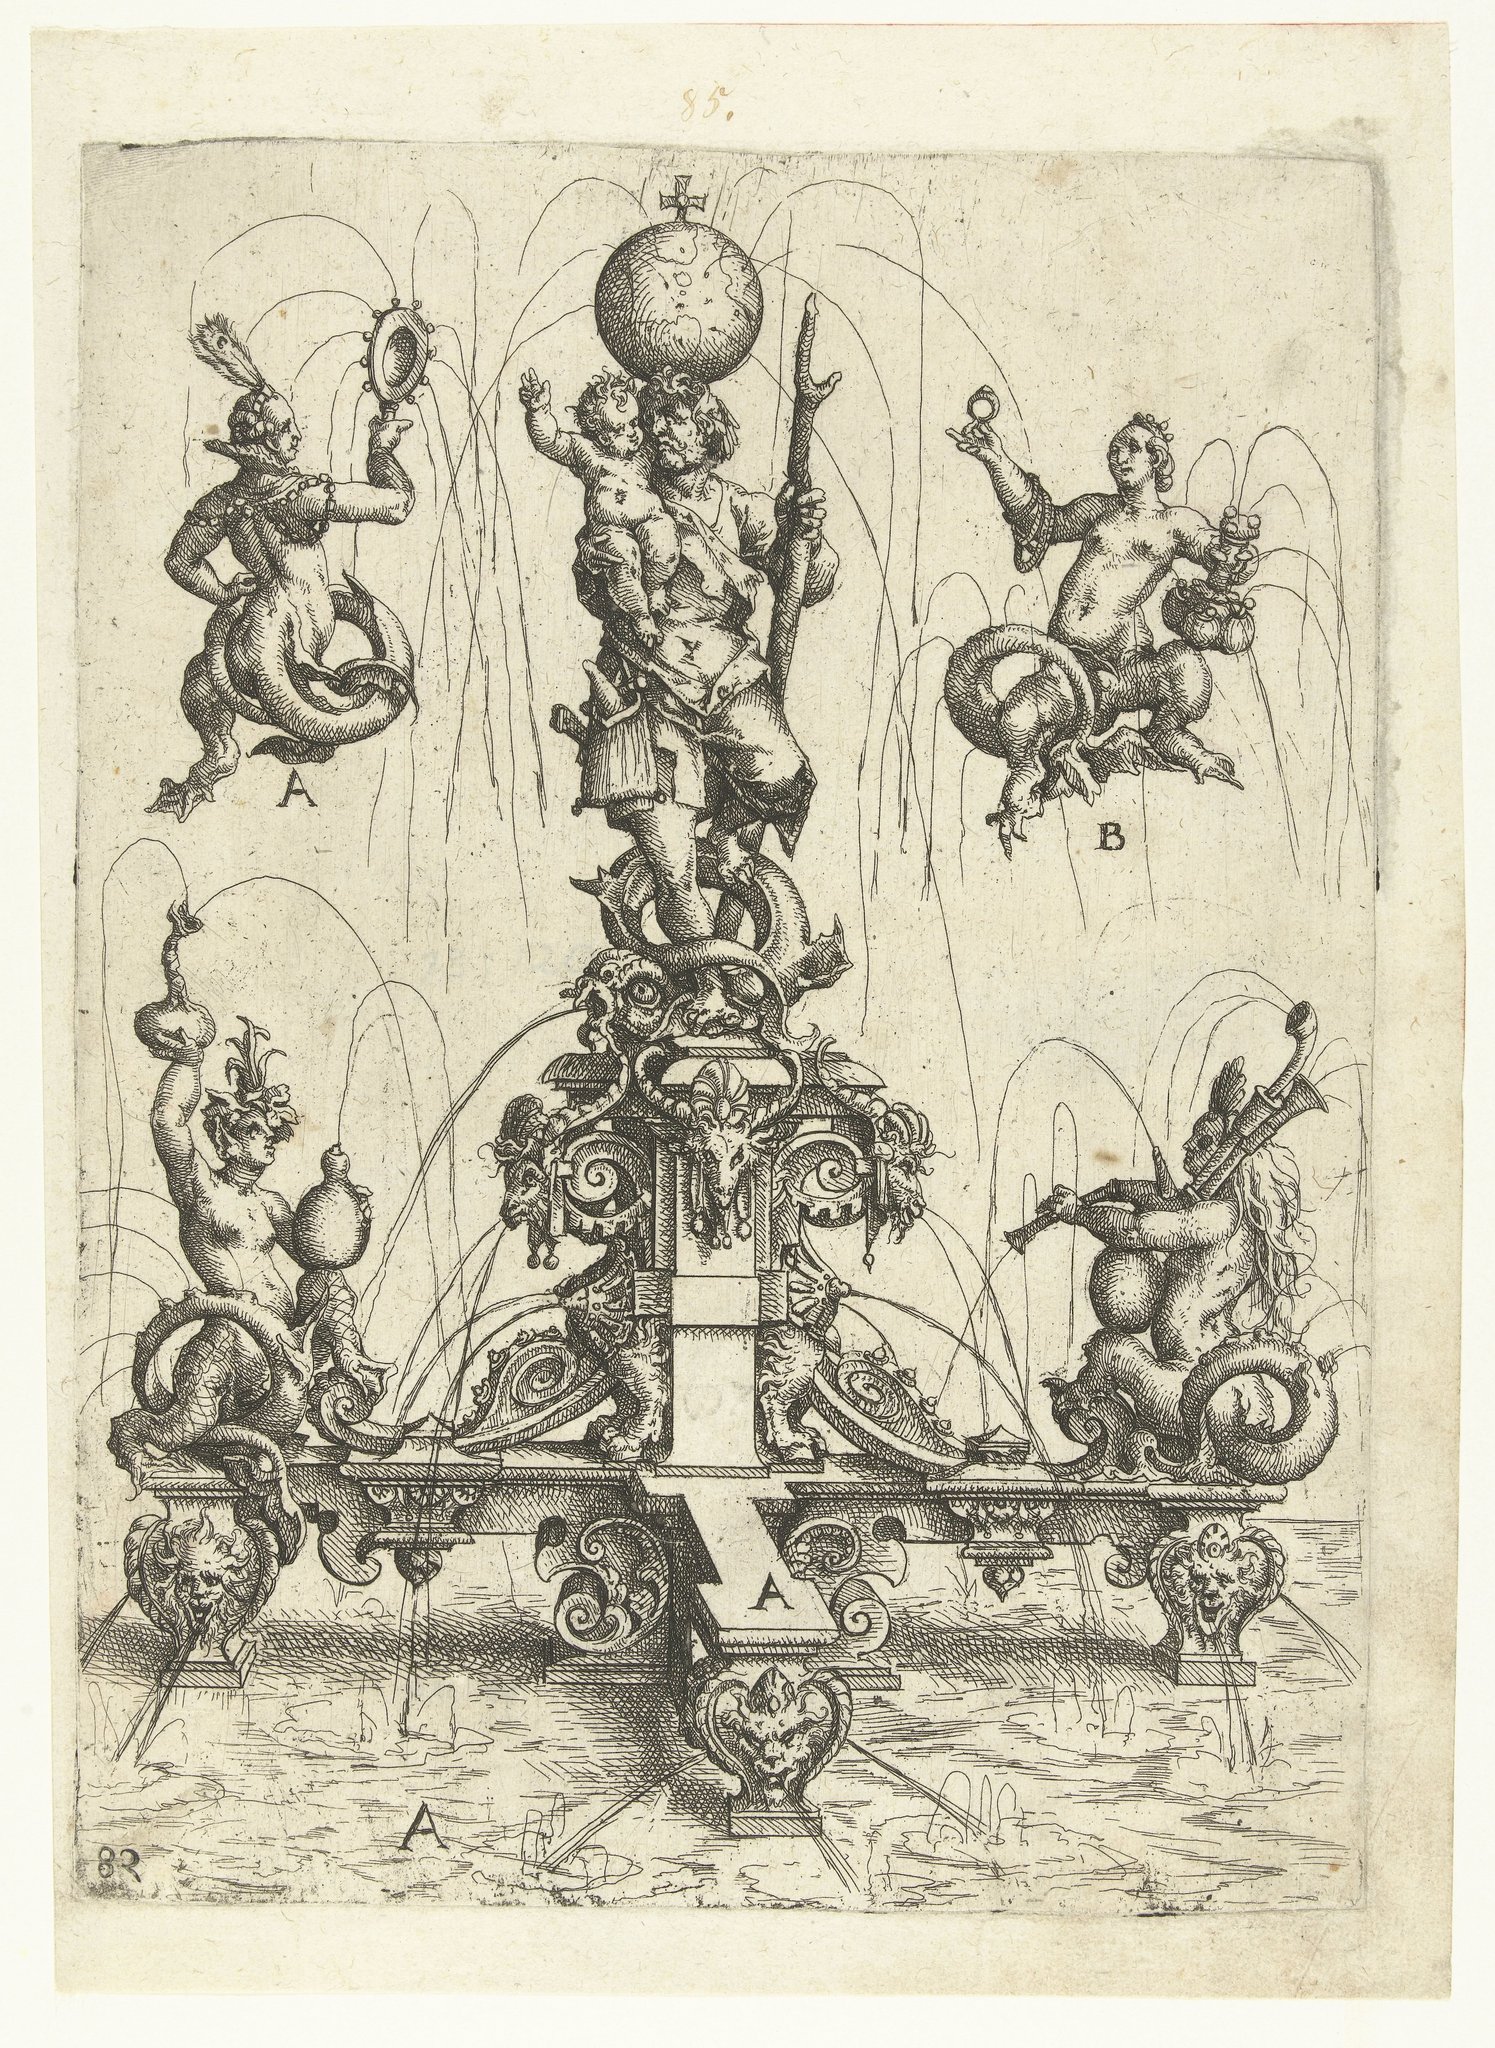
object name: print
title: Titelblad en 11 bladen van "Architectura und Aufstheilung der V Senln (...)" 1593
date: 1560-1598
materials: paper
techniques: etching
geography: germany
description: Christophorus draagt het kind op zijn arm en de wereldbol op zijn hoofd. De sokkel staat op een kruisvormig onderstel waarop aan weerszijden een nereïde zit. 1 van 20 bladen uit een serie (Architectura. Von Ausztheilung, Symmetria und Proportion der fünff Seulen...) bestaande uit 193 bladen en 5 titelbladen, verdeeld over vijf boeken. Het gaat hier om een tweede, uitgebreide editie van de onder Orn Cat I-319 beschreven serie.